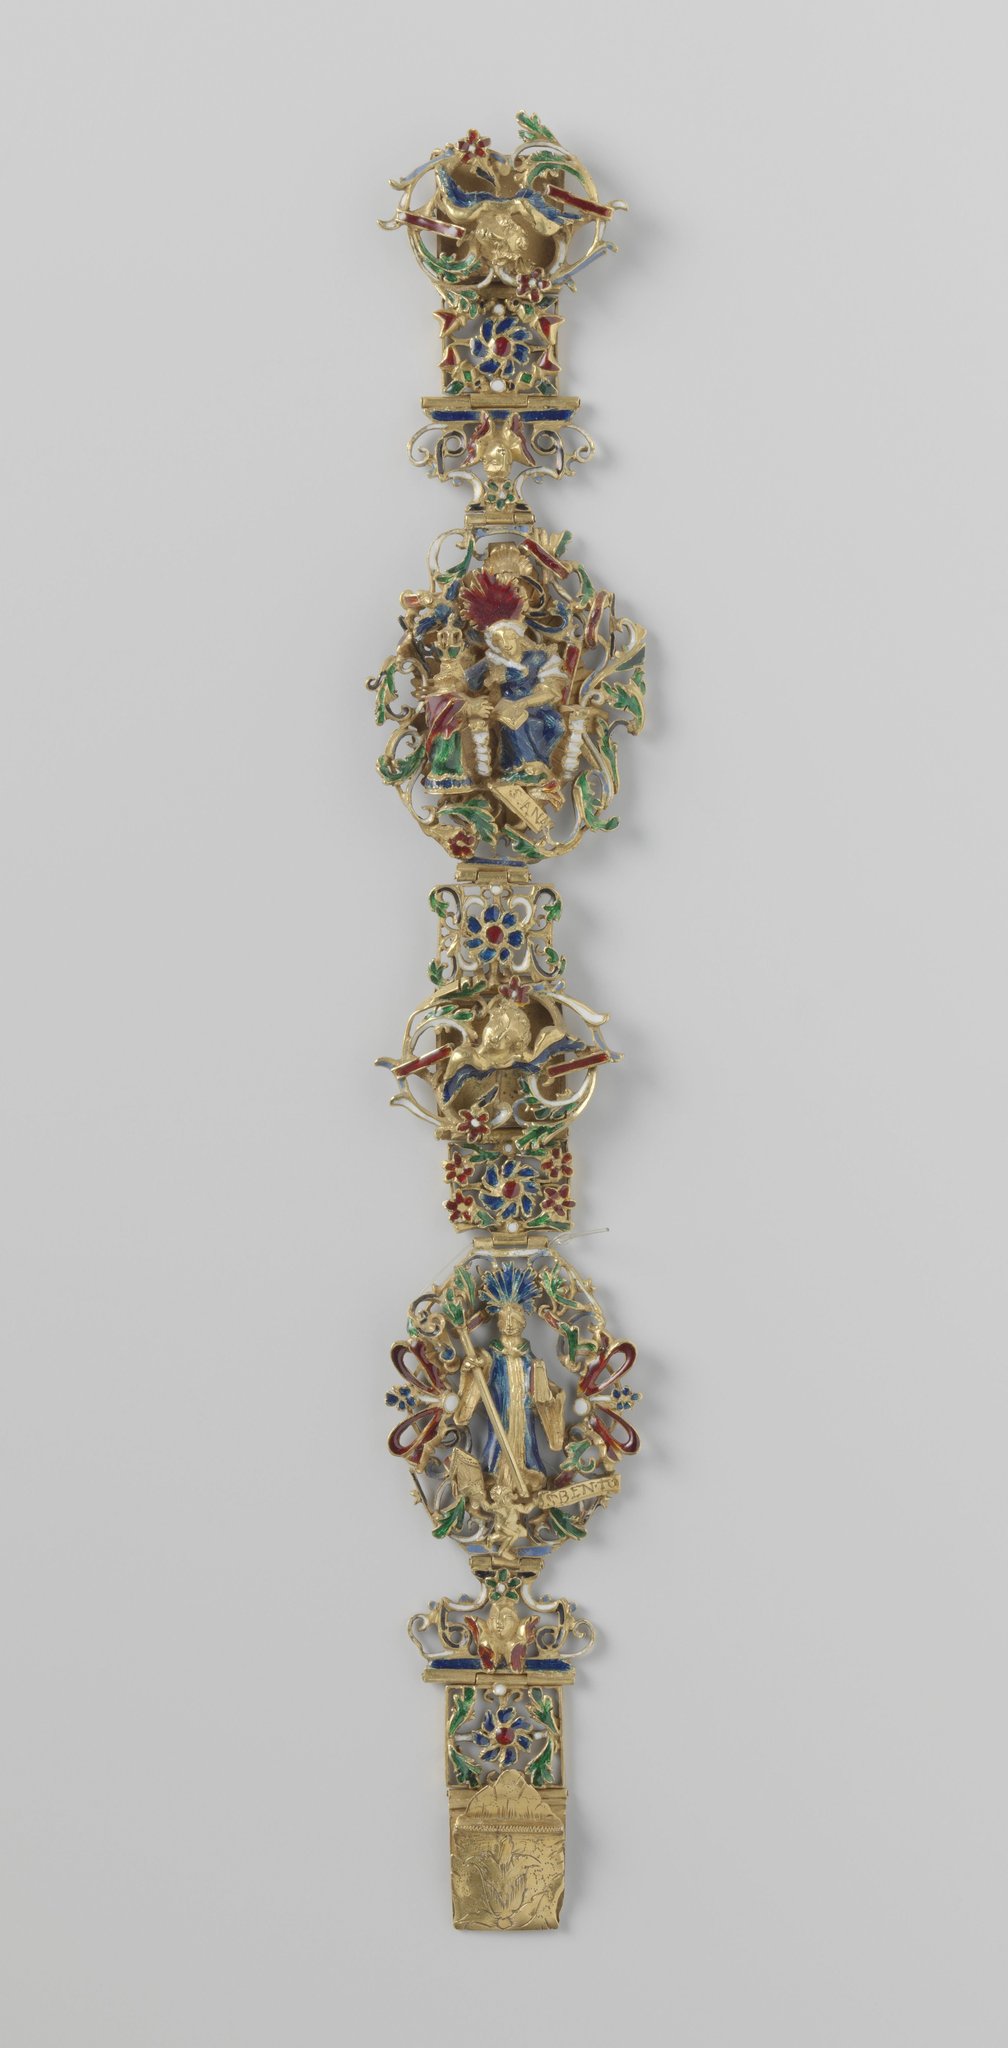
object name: bracelet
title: Armband met religieuze scènes (Benedictus van Nursia en Het onderwijs aan Maria)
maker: david da costa dias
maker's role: jeweler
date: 1610-1640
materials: gold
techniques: enameling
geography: spain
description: Bracelet, Anne with Mary, San Benito and cherubim. Gold and enamel. Spain, c. 1600-1700, by David da Costa Dias.